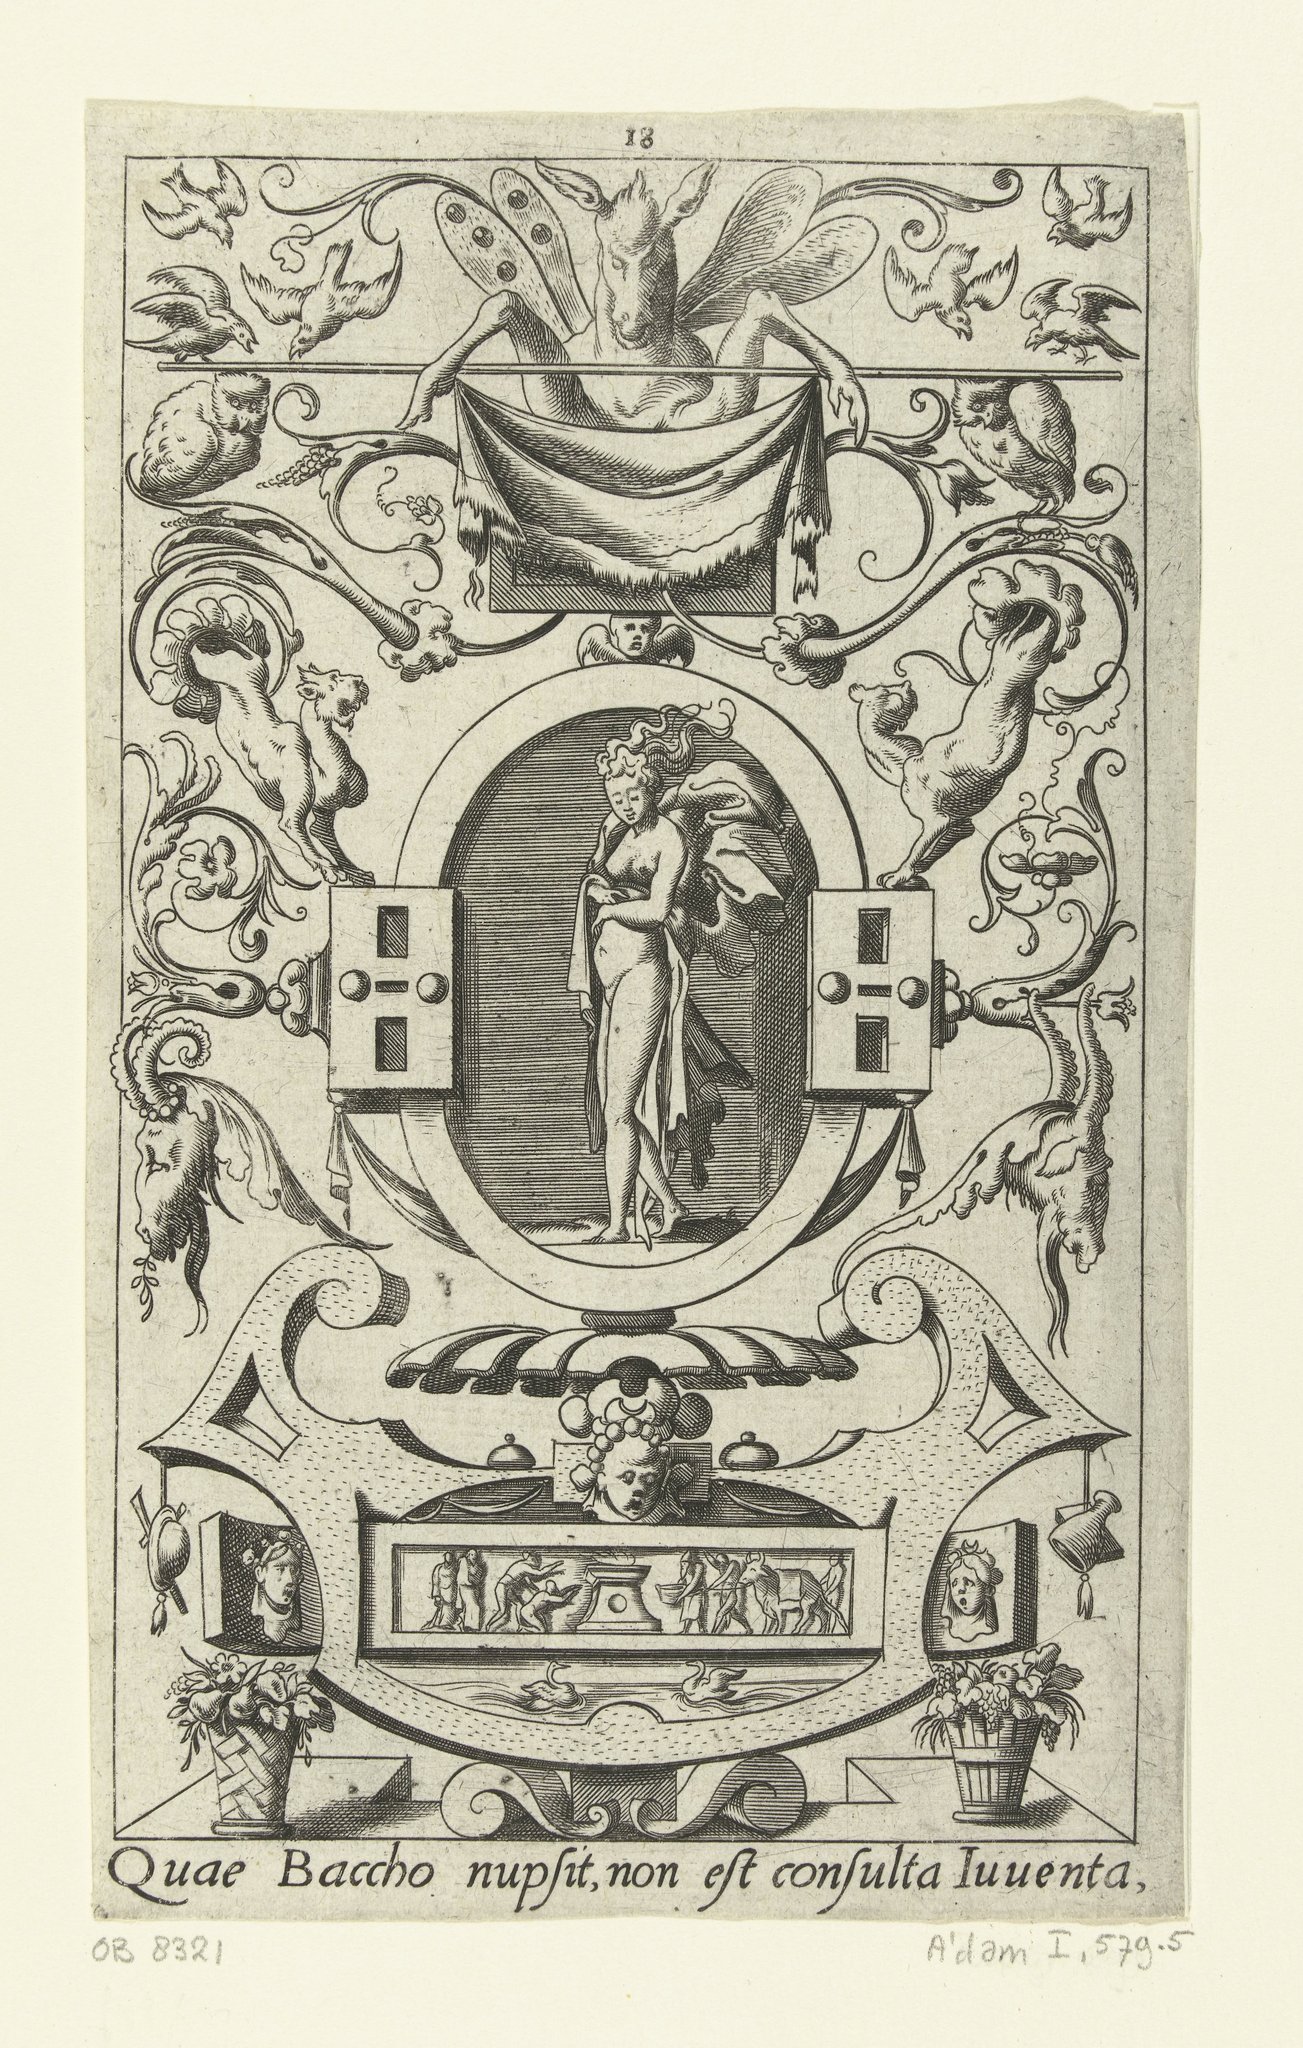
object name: ornament print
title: Ariadne in een ovaal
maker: rené boyvin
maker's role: print maker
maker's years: 1525-1598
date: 1551-1580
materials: paper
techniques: engraving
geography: france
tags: (story of) ariadne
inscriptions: collector's mark: Lugt 240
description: Onderaan staat een Latijnse tekst. Uit serie bladen met vlakdecoraties van goden en godinnen in een omlijsting van grotesken met fantastische wezens, dieren, guirlandes en mascarons. Dit blad is afkomstig uit een latere editie: het oorspronkelijke bladnummer 5 is vervangen door 18.